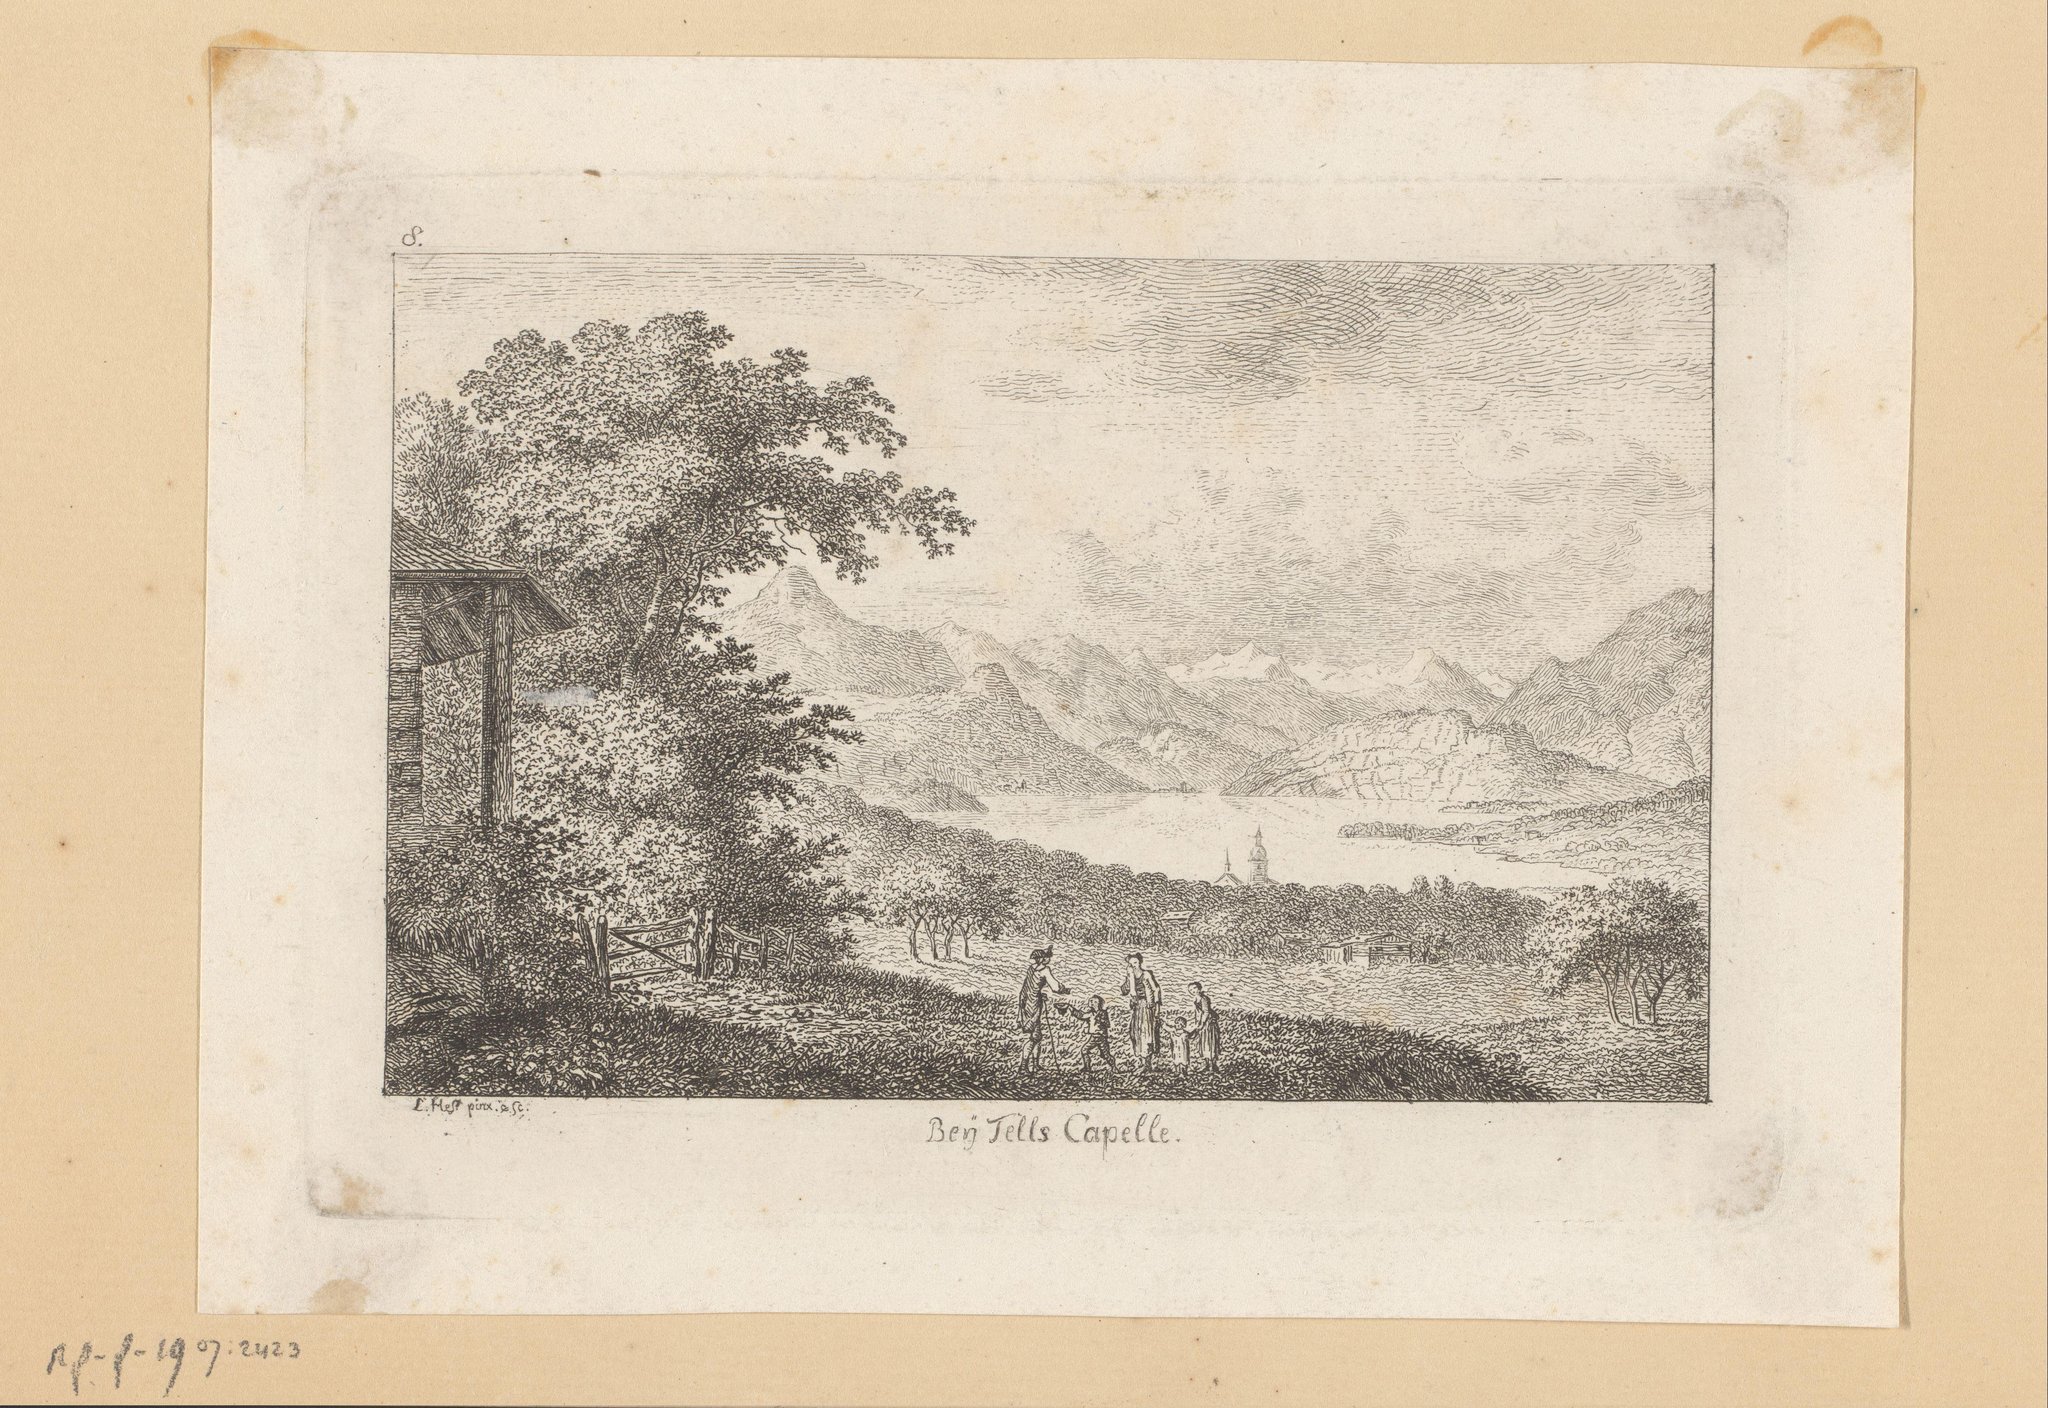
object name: print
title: Bergachtig landschap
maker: ludwig hess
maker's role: painter, print maker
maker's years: 1760-1800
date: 1798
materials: paper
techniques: etching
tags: landscapes with waters, waterscapes, seascapes (in the temperate zone), 'en route', traveller under way, mountains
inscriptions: collector's mark: Lugt 2228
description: Onderdeel van een serie van mogelijk tien prenten met bergachtige landschappen met reizigers. Prent nummer 10 in British Museum: 1878,0713.2123.